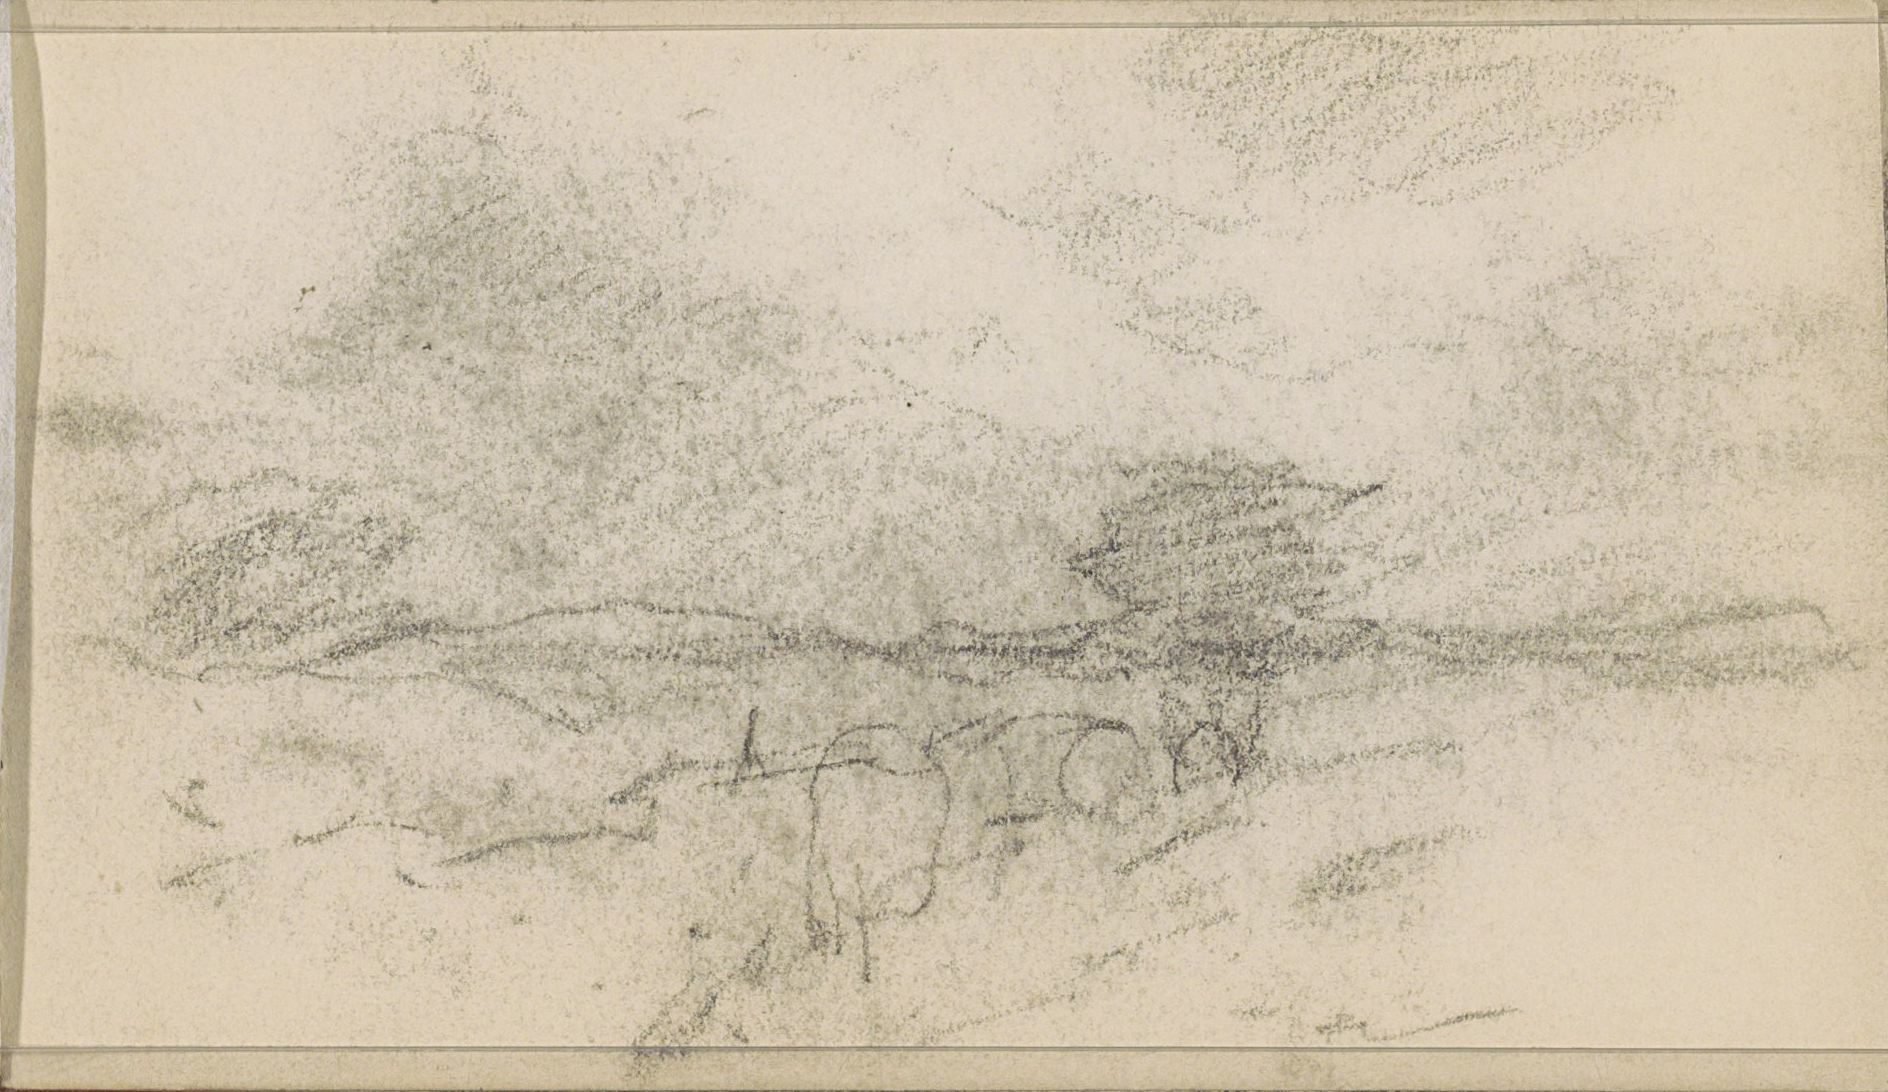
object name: sketchbook leaf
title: Landschap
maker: anton mauve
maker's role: draughtsman, painter, print maker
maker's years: 1838-1888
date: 1876-1879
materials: chalk, paper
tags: landscapes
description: Blad 20 recto uit een schetsboek met 33 bladen.